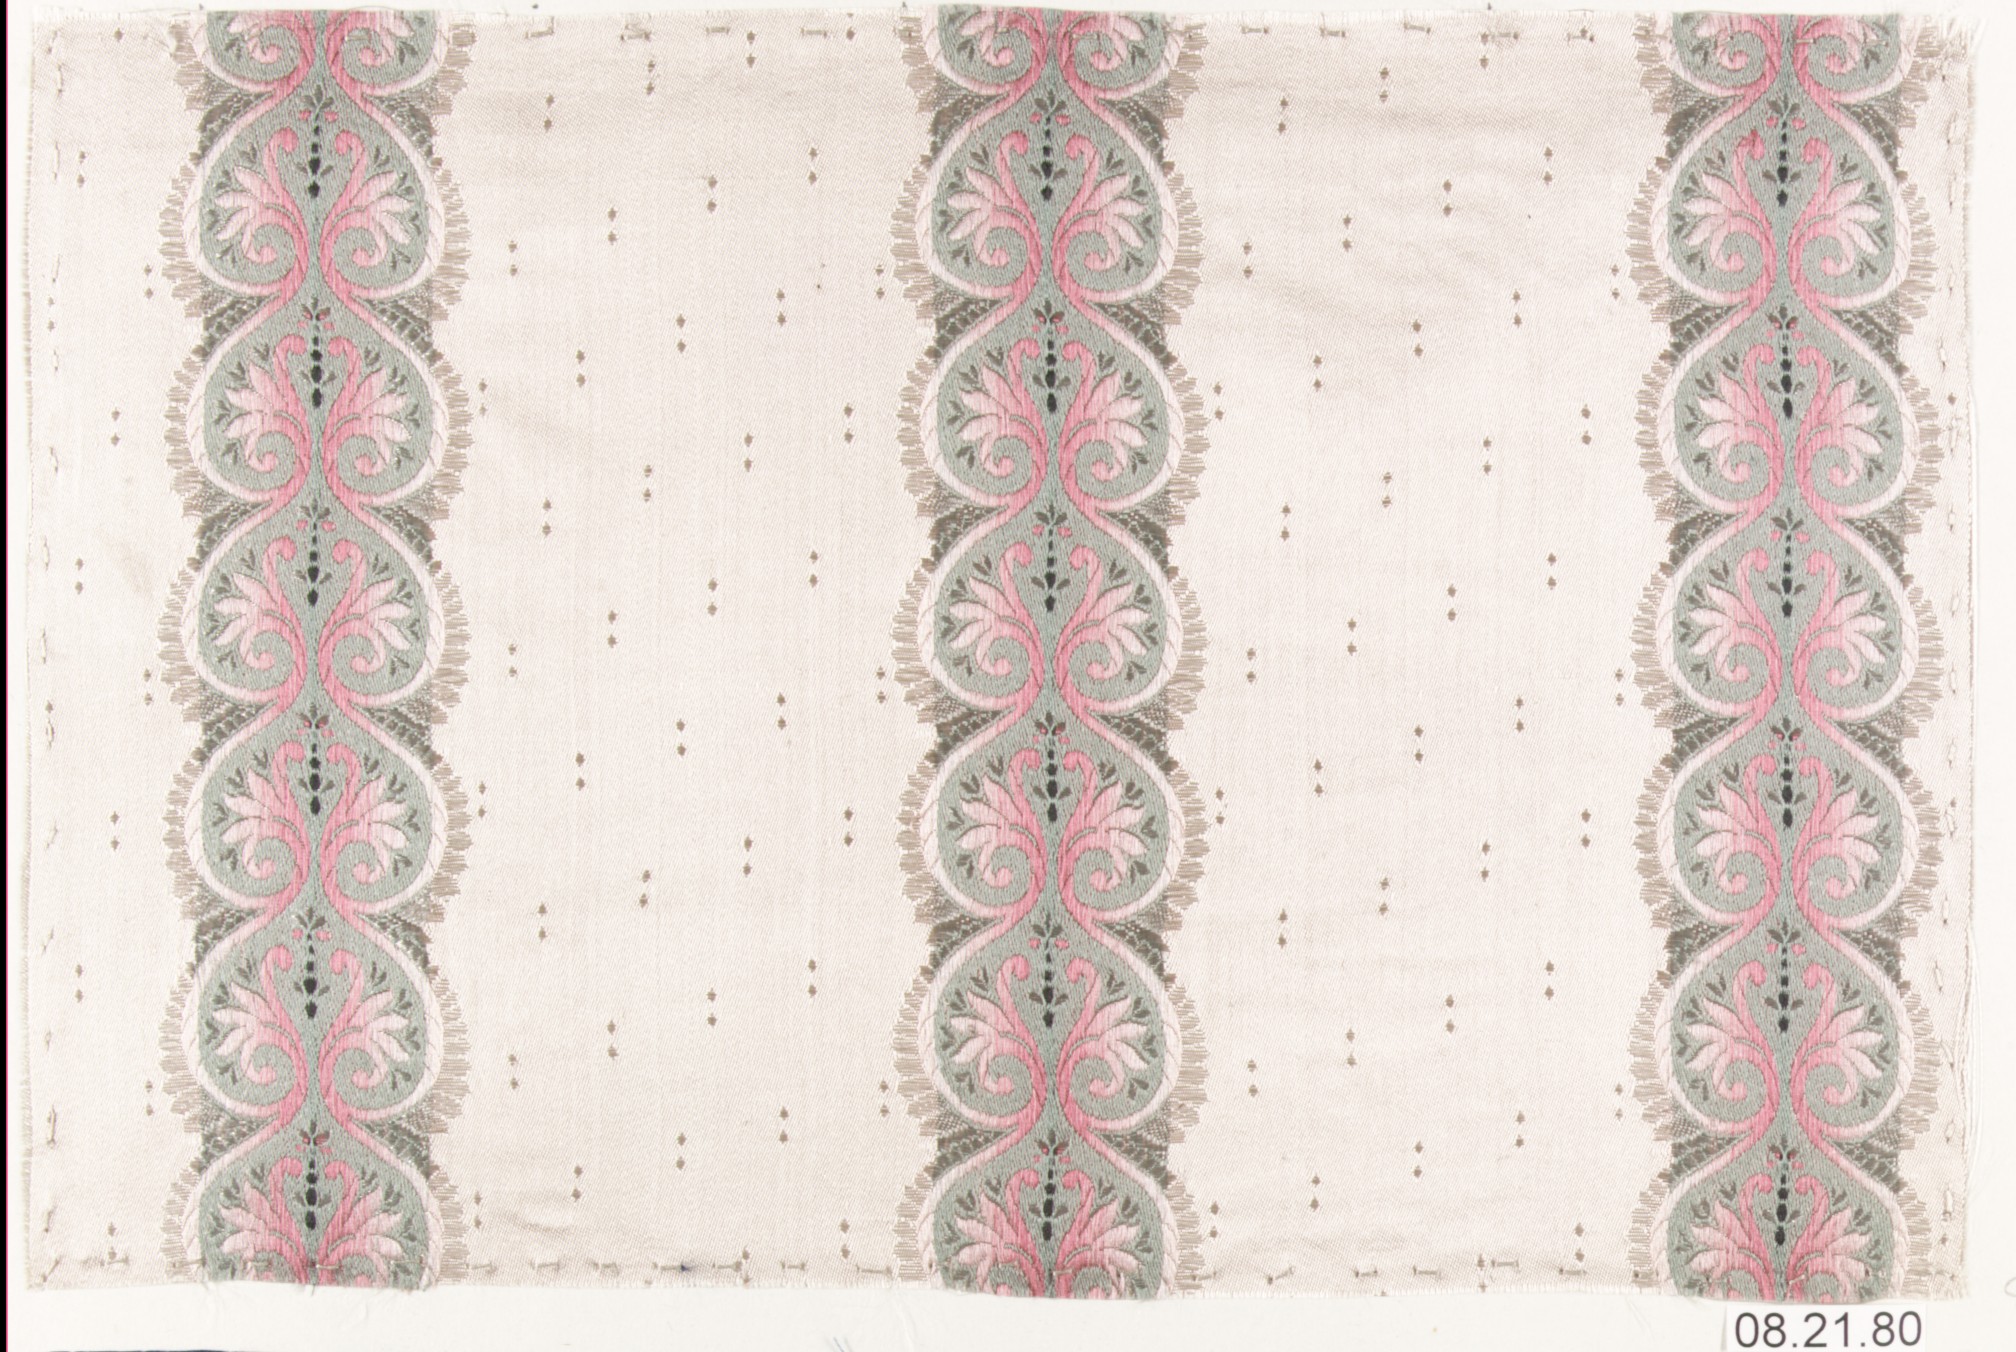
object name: textile sample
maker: Anonymous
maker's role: designer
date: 1900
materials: silk